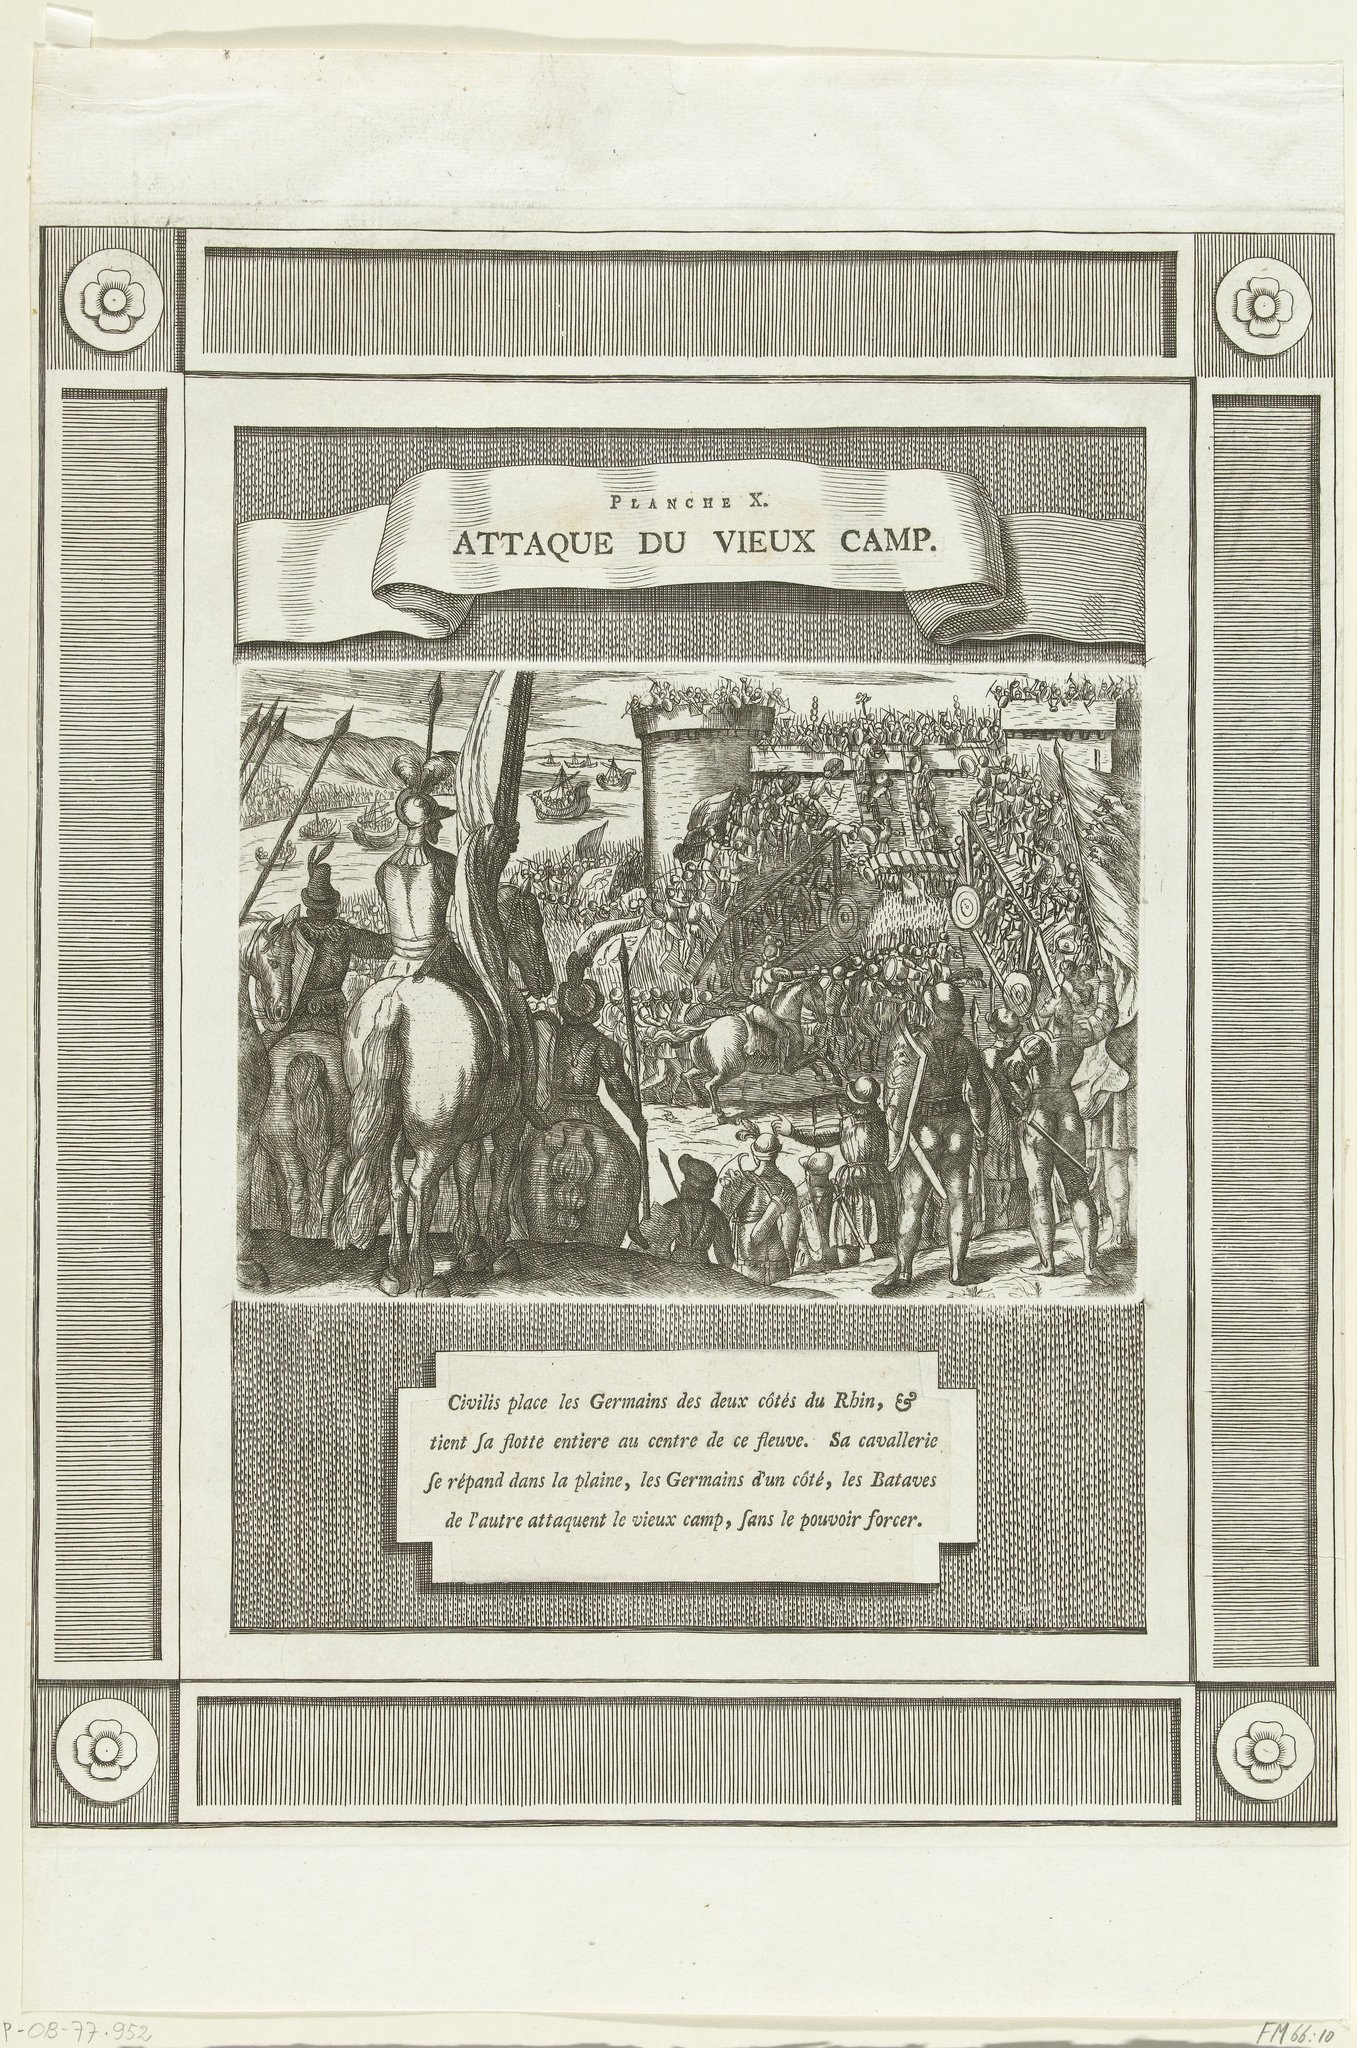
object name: print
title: Civilus gebruikt verplaatsbare houten bruggen bij de aanval op een vesting, 69-70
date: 1768-1770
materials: paper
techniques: engraving, etching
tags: battle, fighting in general, extinct, 'historical' peoples (with name), netherlands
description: Civilus gebruikt verplaatsbare houten bruggen bij de aanval op een vesting. Prent 10 in een serie over de Bataafse Opstand, gekopieerd naar de reeks Batavorum cum Romanis bellum van Antonio Tempesta (Otto Vaenius, Antwerpen 1612). Illustratie voor: Marquis de St. Simon, Histoire de la guerre des Bataves et des Romains, d'après César; Corneille Tacite, Aux dépens de Marc-Michel Rey, Amsterdam 1770. Voorstellingen gedrukt in een grote ornamentele omlijsting waarin bovenaan een uitgeknipte titel en onderaan een onderschrift in het Frans is geplakt.